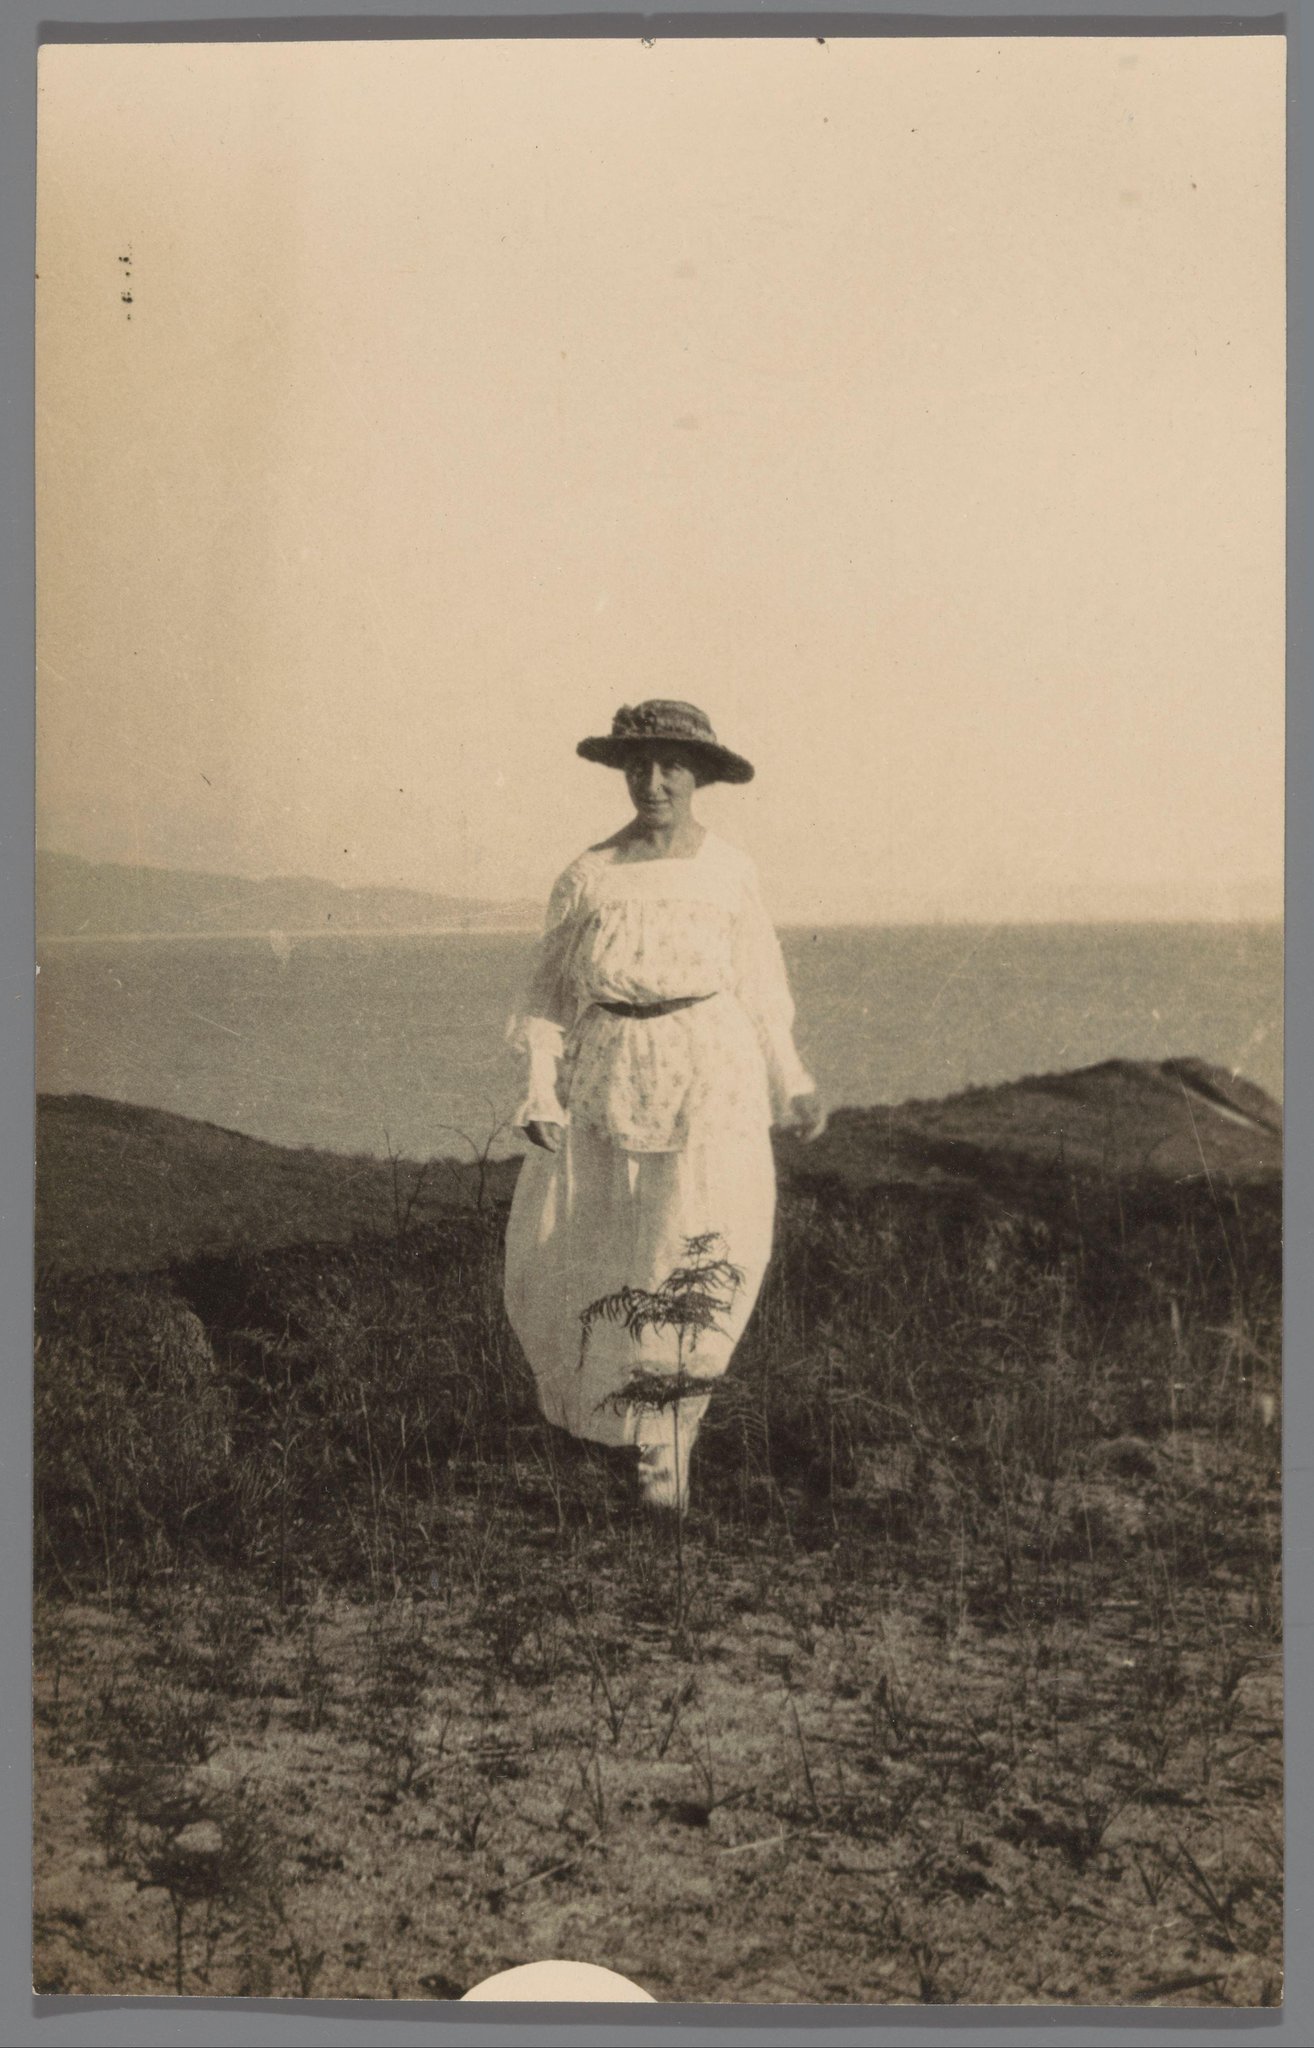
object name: photograph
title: Portret van onbekende vrouw bij een kust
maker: Anonymous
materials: paper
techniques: gelatin silver print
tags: anonymous historical persons portrayed in a double portrait - bb - woman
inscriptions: inscription: ‘Voor Kees/ van tante Cor’